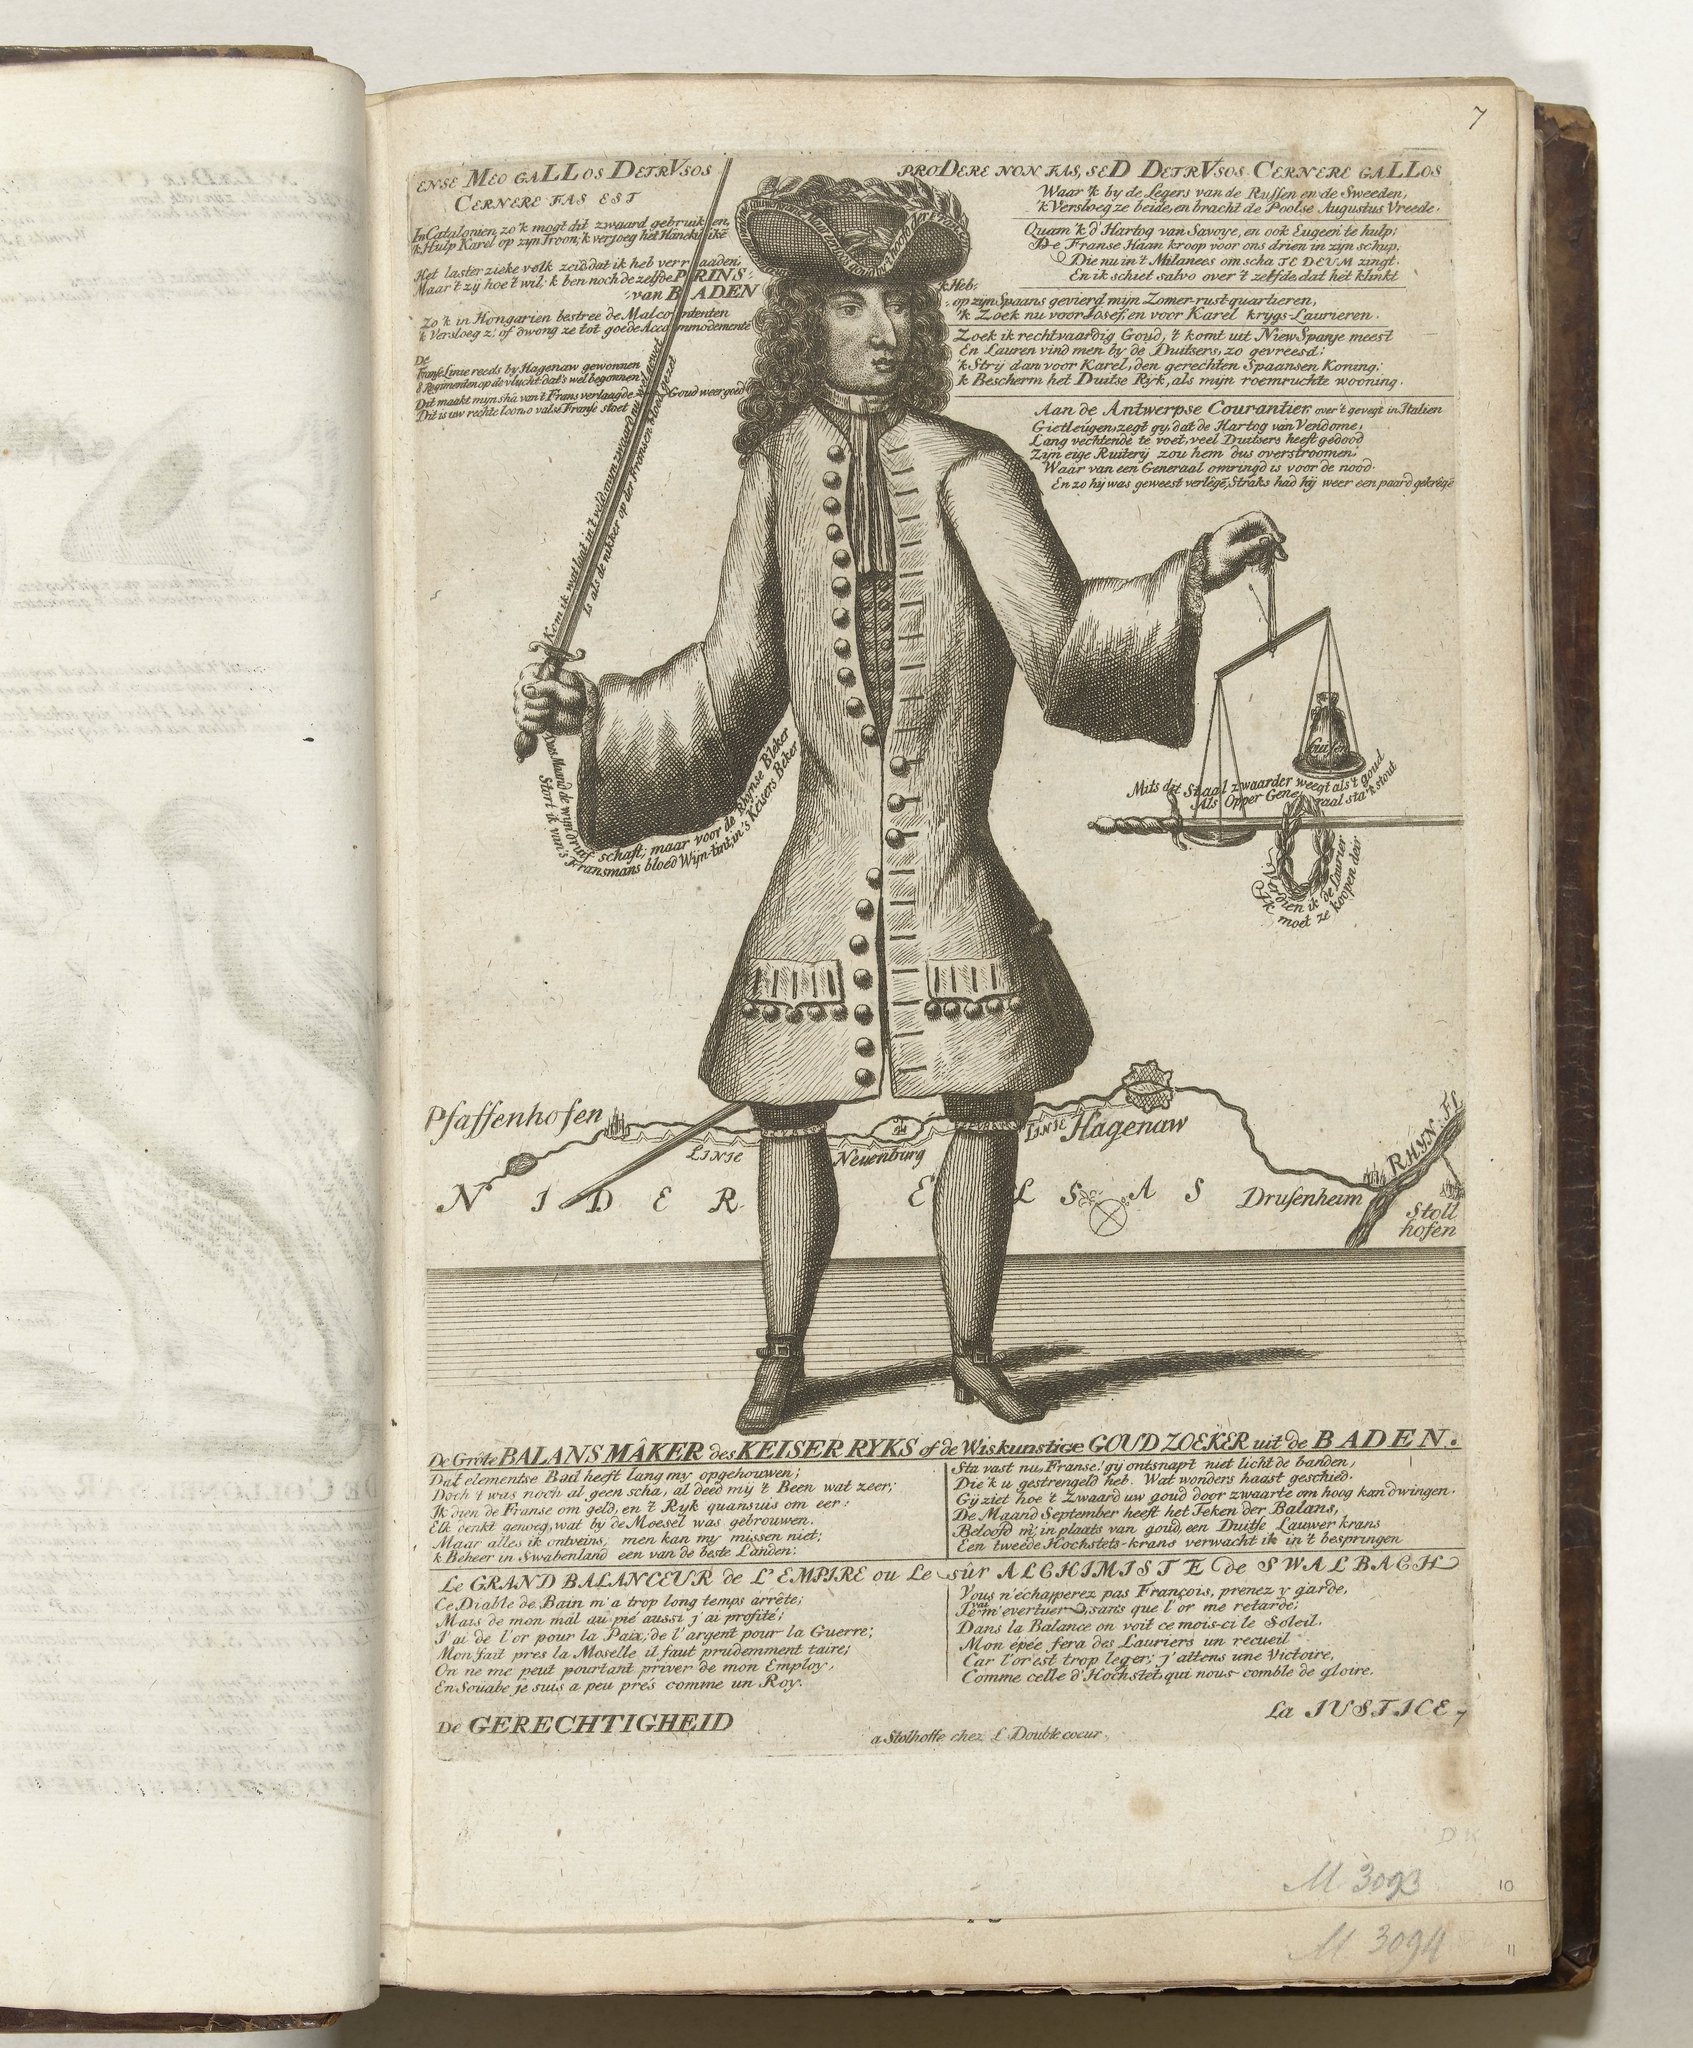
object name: print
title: Spotprent op Lodewijk Willem I, markgraaf van Baden-Baden, 1705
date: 1706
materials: paper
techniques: etching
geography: amsterdam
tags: weighing gold or money, political caricatures and satires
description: Spotprent op Lodewijk Willem I, markgraaf van Baden-Baden, staande met zwaard in de hand, in de andere hand met een balans een zwaard wegend tegen een zak met goudstukken. Met verzen in het Nederlands en Frans in de plaat. Prent nr. 7 (De Gerechtigheid - La Justice) in de serie van 7 prenten in de Koninklyke Almanach van 1705 in het prentwerk uitgegeven onder de verzameltitel 't Lust-Hof van Momus met de gebundelde series van spotprenten tijdens de jaren 1701-1713 van de Spaanse Successieoorlog.